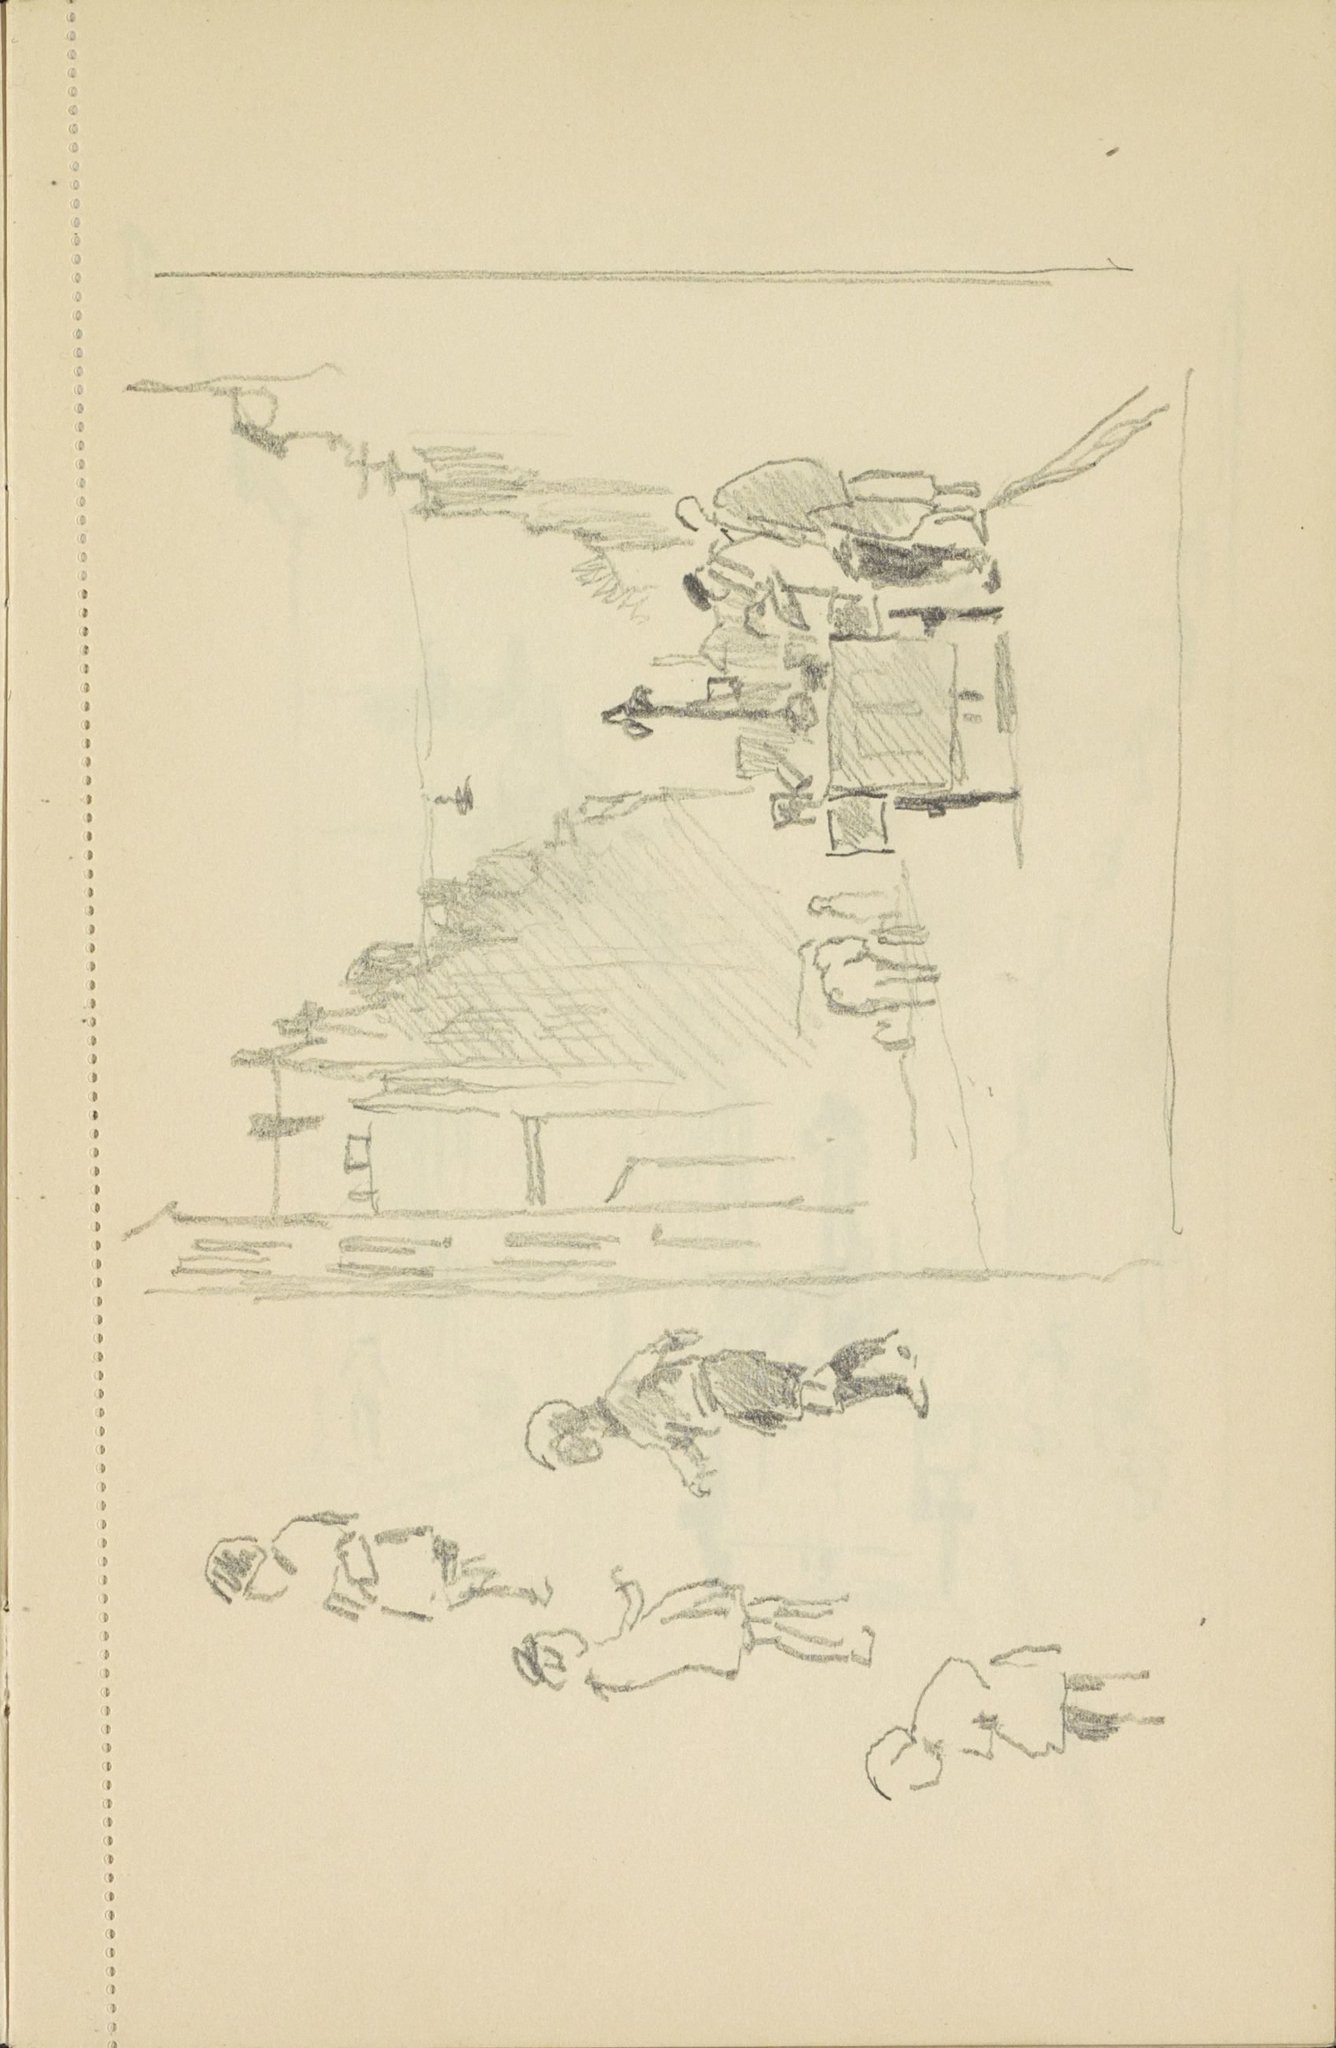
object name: sketchbook leaf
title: Figuren en een bakfiets op een straat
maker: cornelis vreedenburgh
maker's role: draughtsman, print maker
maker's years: 1880-1946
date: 1890-1946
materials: paper, pencil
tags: child, street (+ city(-scape) with figures, staffage)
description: Tevens studies van kinderen. Blad 23 recto uit een schetsboek met 73 bladen.